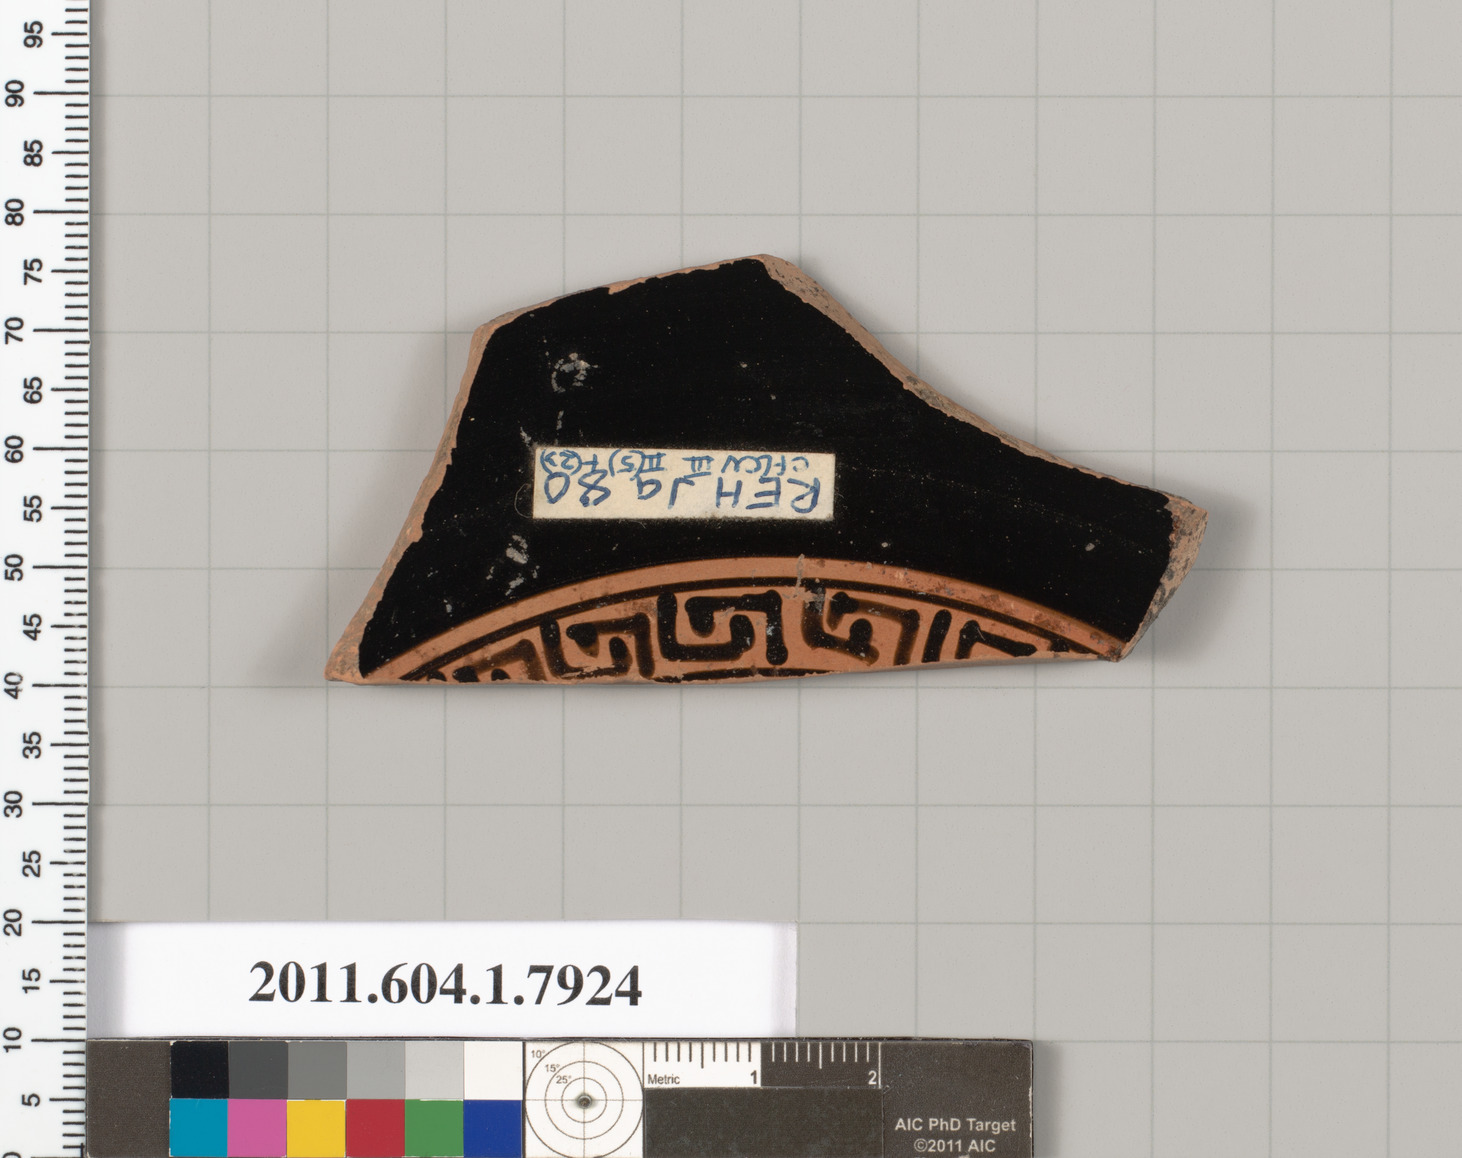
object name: kylix fragment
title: Terracotta fragment of a kylix (drinking cup)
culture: greek, attic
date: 450 BCE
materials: terracotta